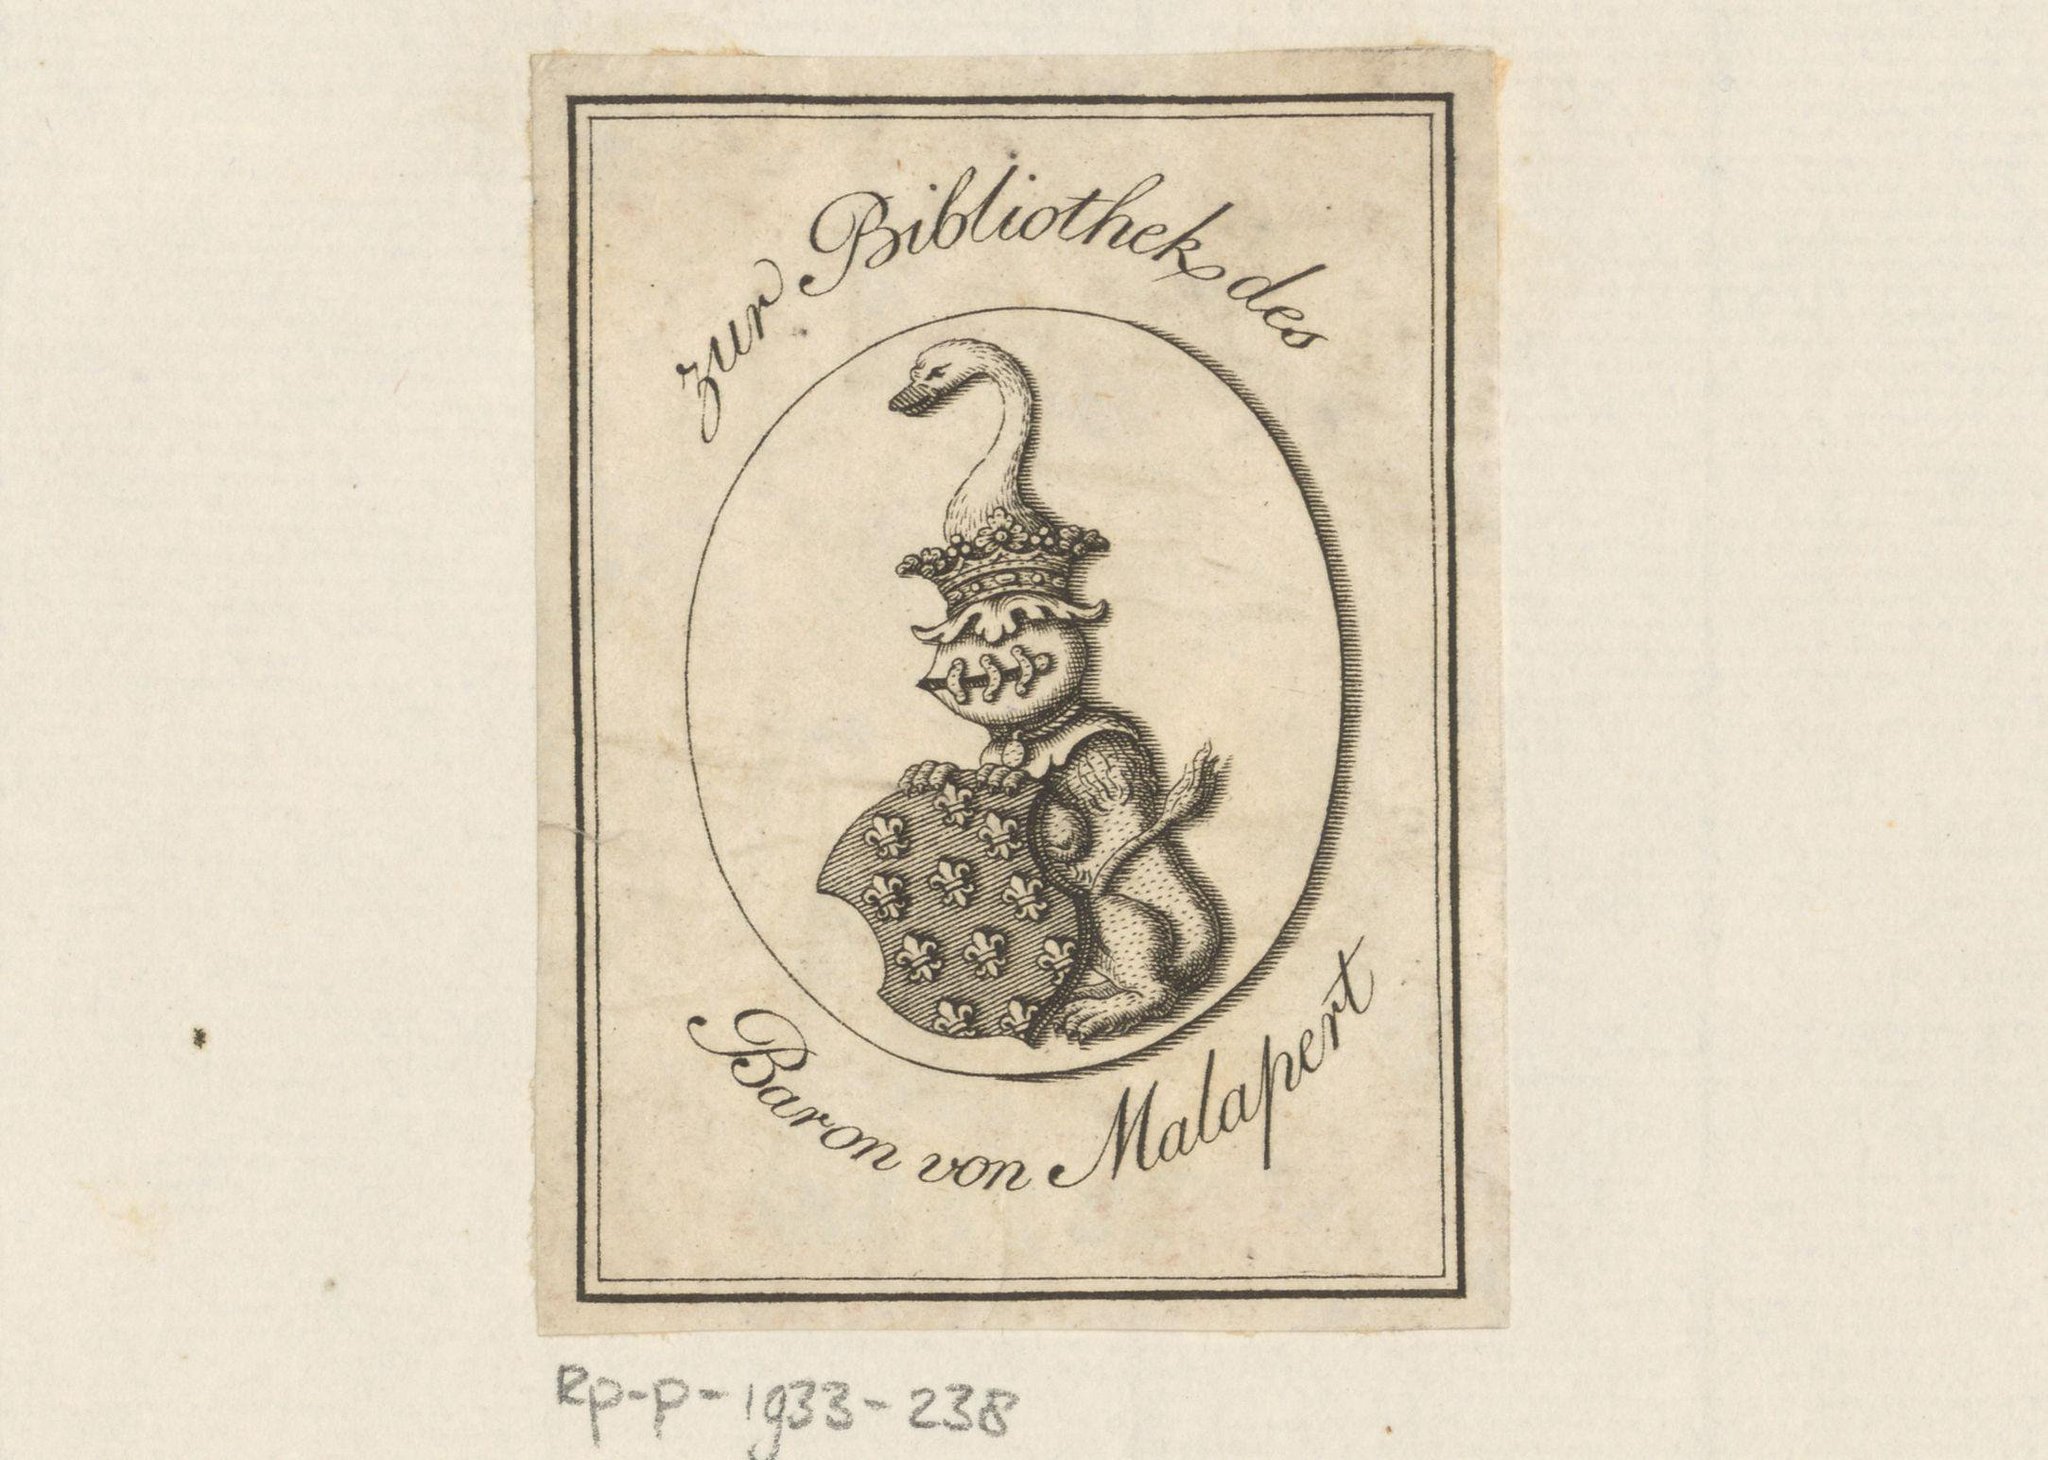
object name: bookplate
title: Ex libris van zur Bibliothek des Baron von Malapert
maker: Anonymous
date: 1800-1899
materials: paper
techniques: engraving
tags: armorial bearing, heraldry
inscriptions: collector's mark: Lugt 3502, collector's mark: Lugt 2760